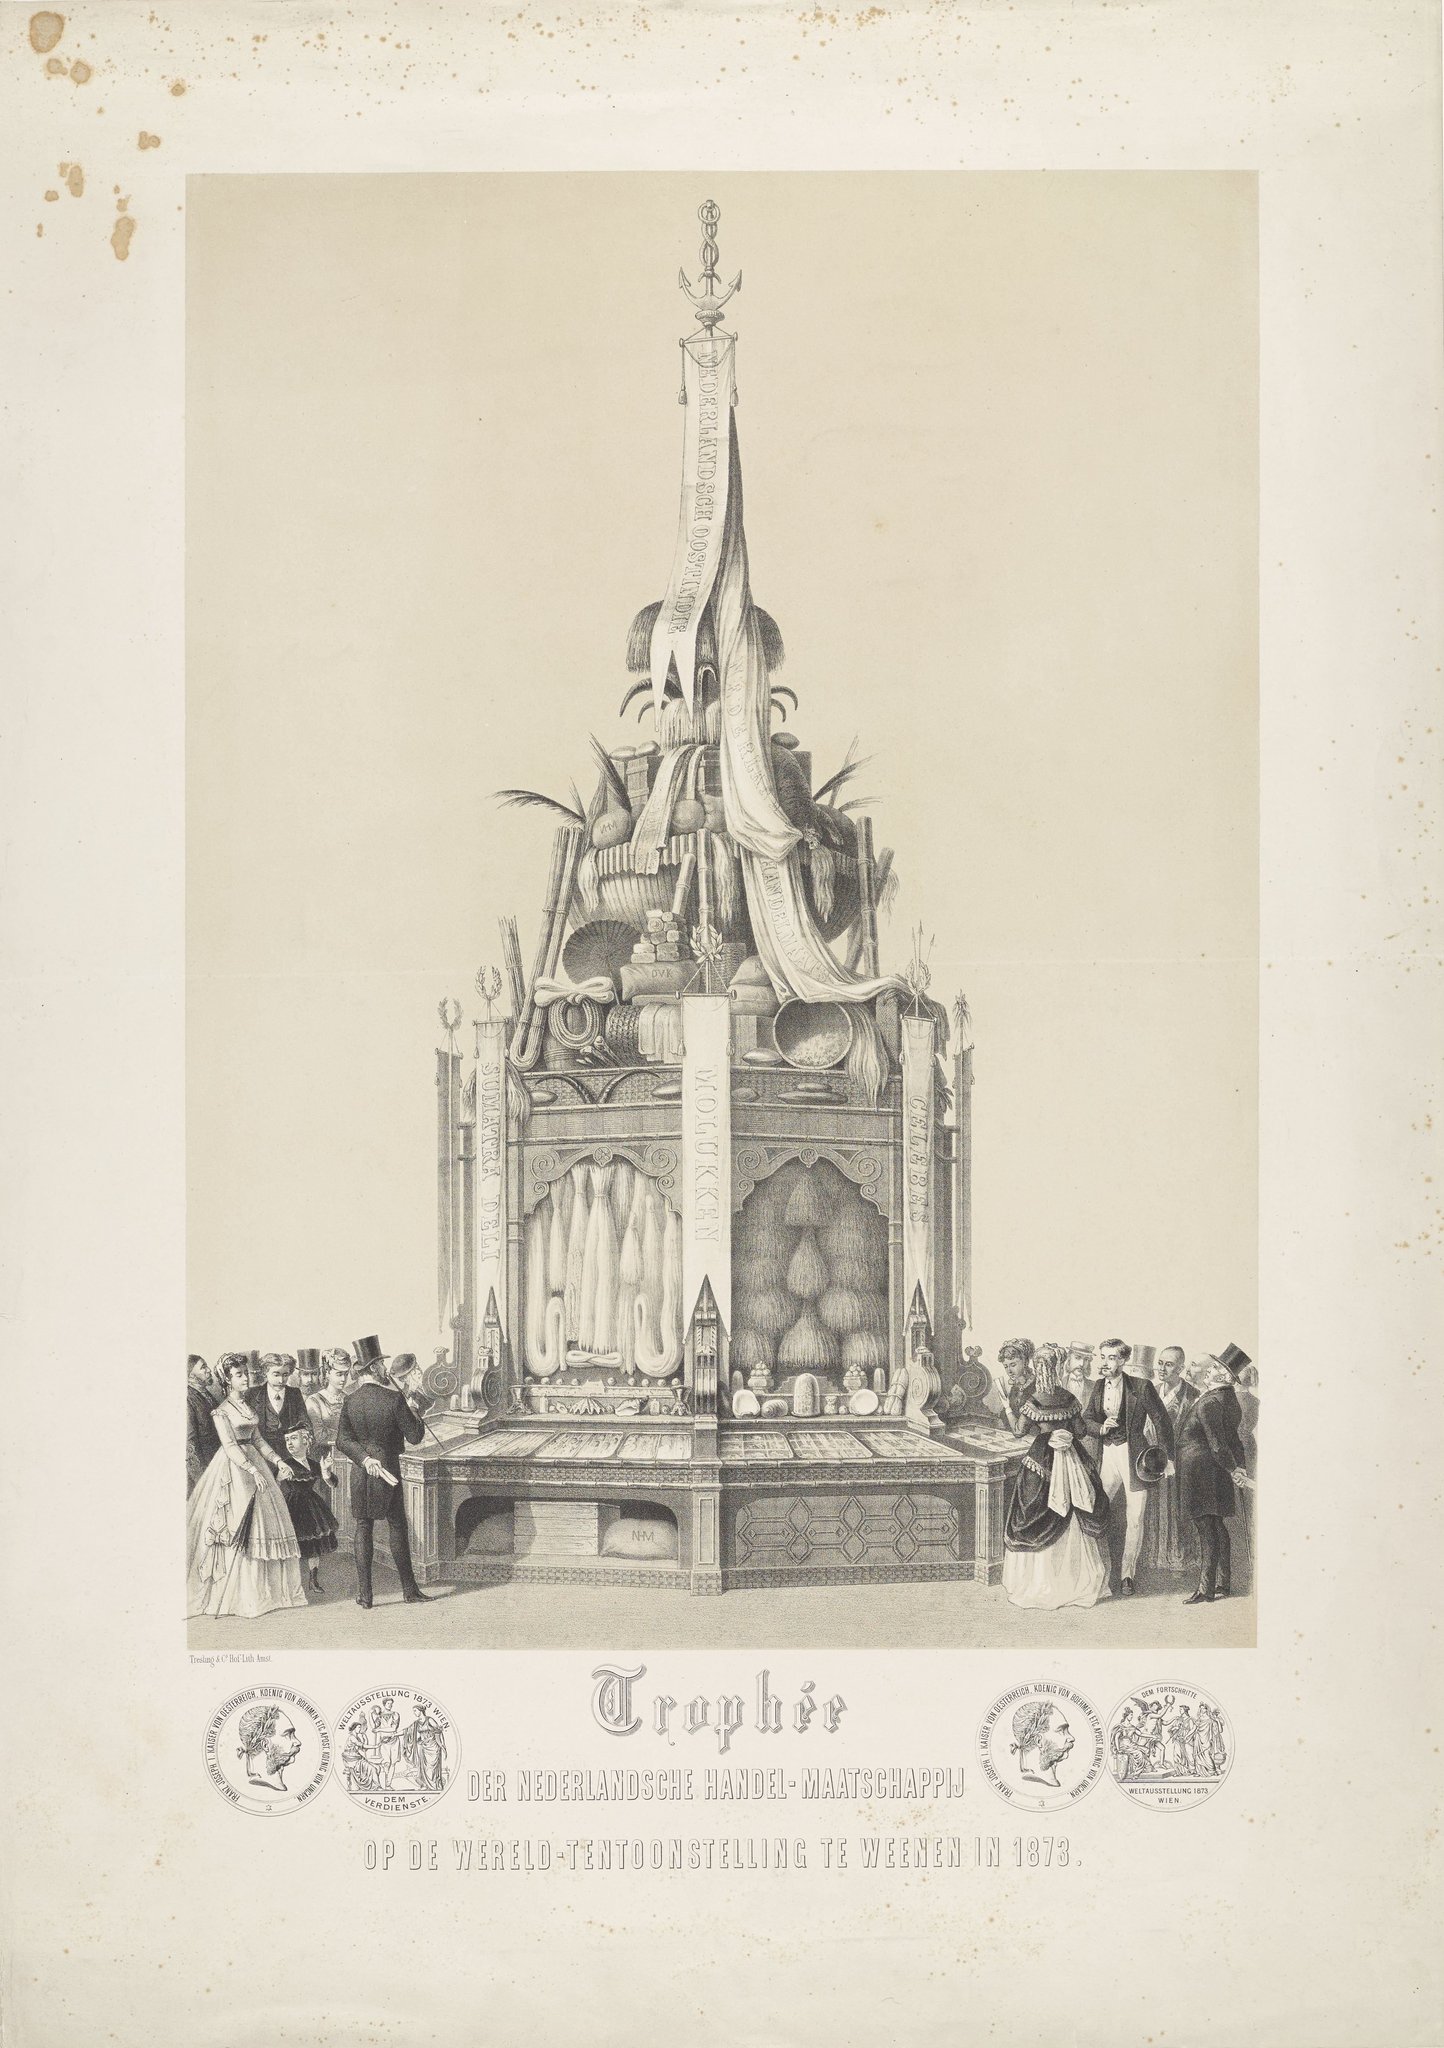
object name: print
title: Trophie der Nederlandsche Handel-Maatschappij op de Wereld-tentoonstelling te Weenen in 1873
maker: Anonymous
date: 1873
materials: paper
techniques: tone lithography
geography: amsterdam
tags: world fair, world exhibition, dutch east indies, the, vienna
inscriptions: collector's mark: Lugt 2228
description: Trofee, een bouwwerk opgebouwd uit producten uit Nederlands-Indië, opgericht door de Nederlandse Handelsmaatschappij op de Wereldtentoonstelling te Wenen in mei 1873. Onderaan de twee gewonnen medailles.